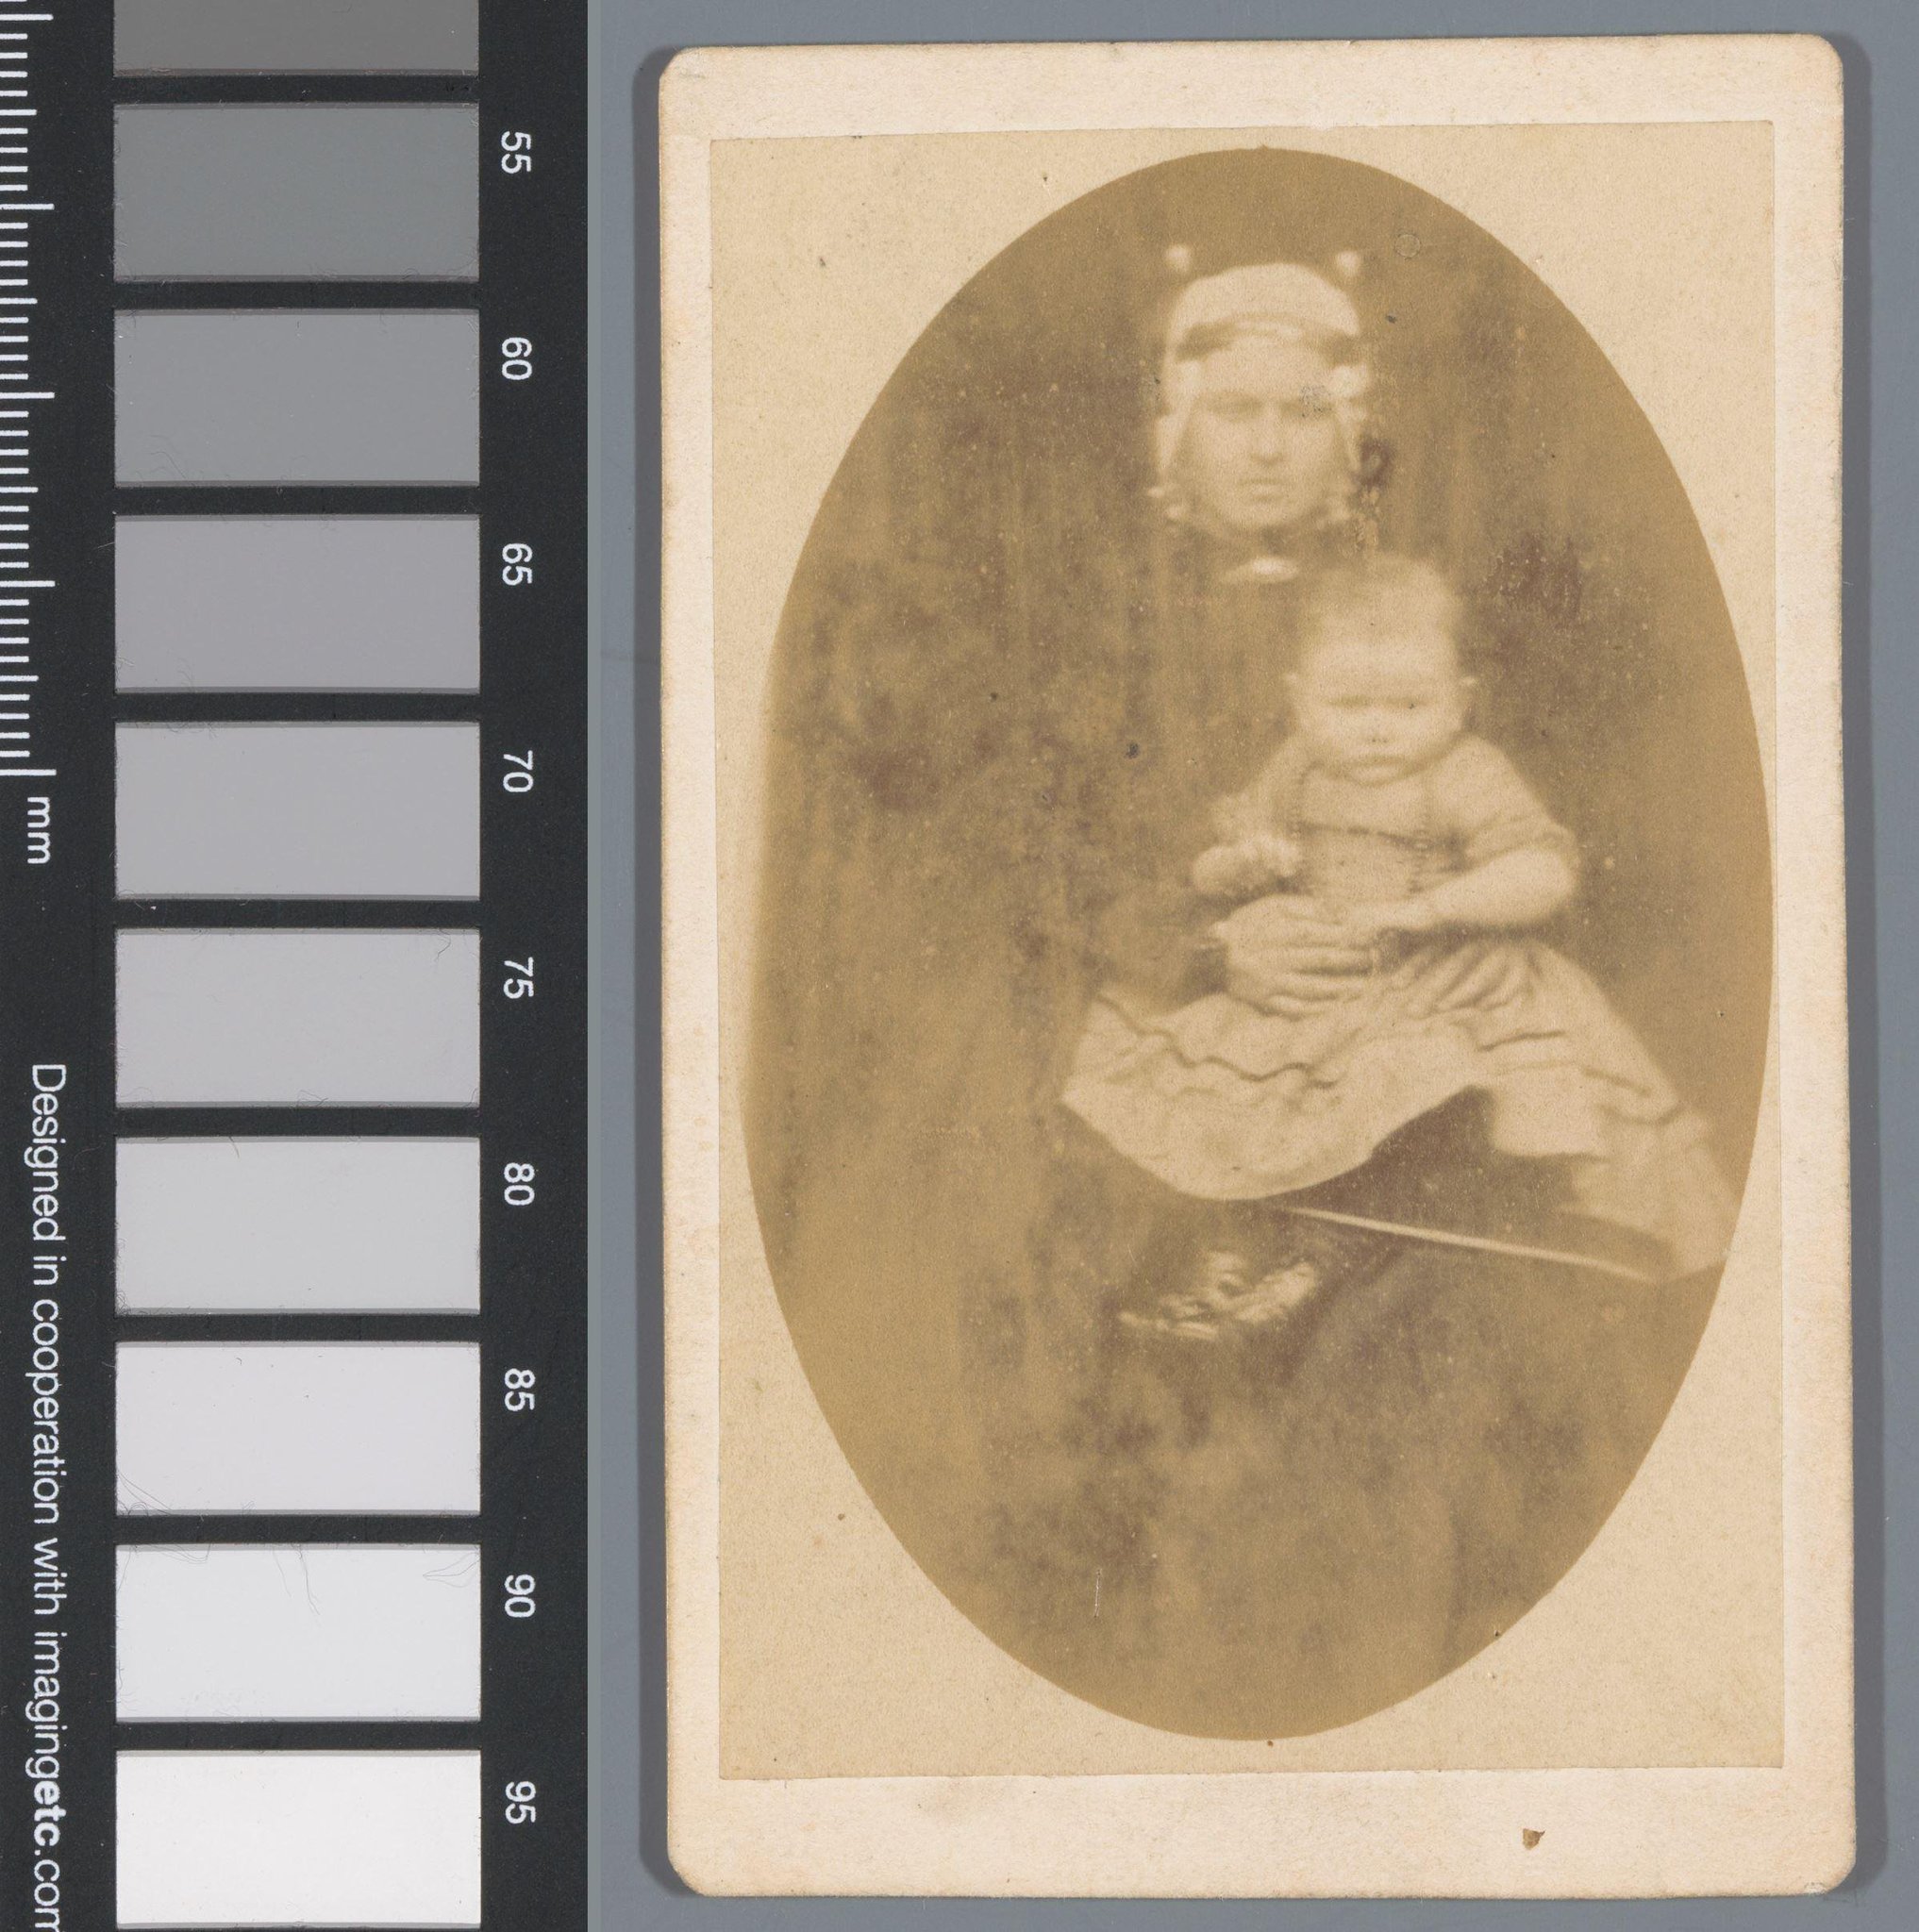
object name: photograph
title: Portret van Dieuwertje Kalff met een baby op schoot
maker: Anonymous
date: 1855-1885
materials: cardboard, paper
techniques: albumen print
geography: netherlands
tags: historical persons, head-gear: cap, mother and baby or young child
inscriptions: inscription: ‘Diewertje Kalff’